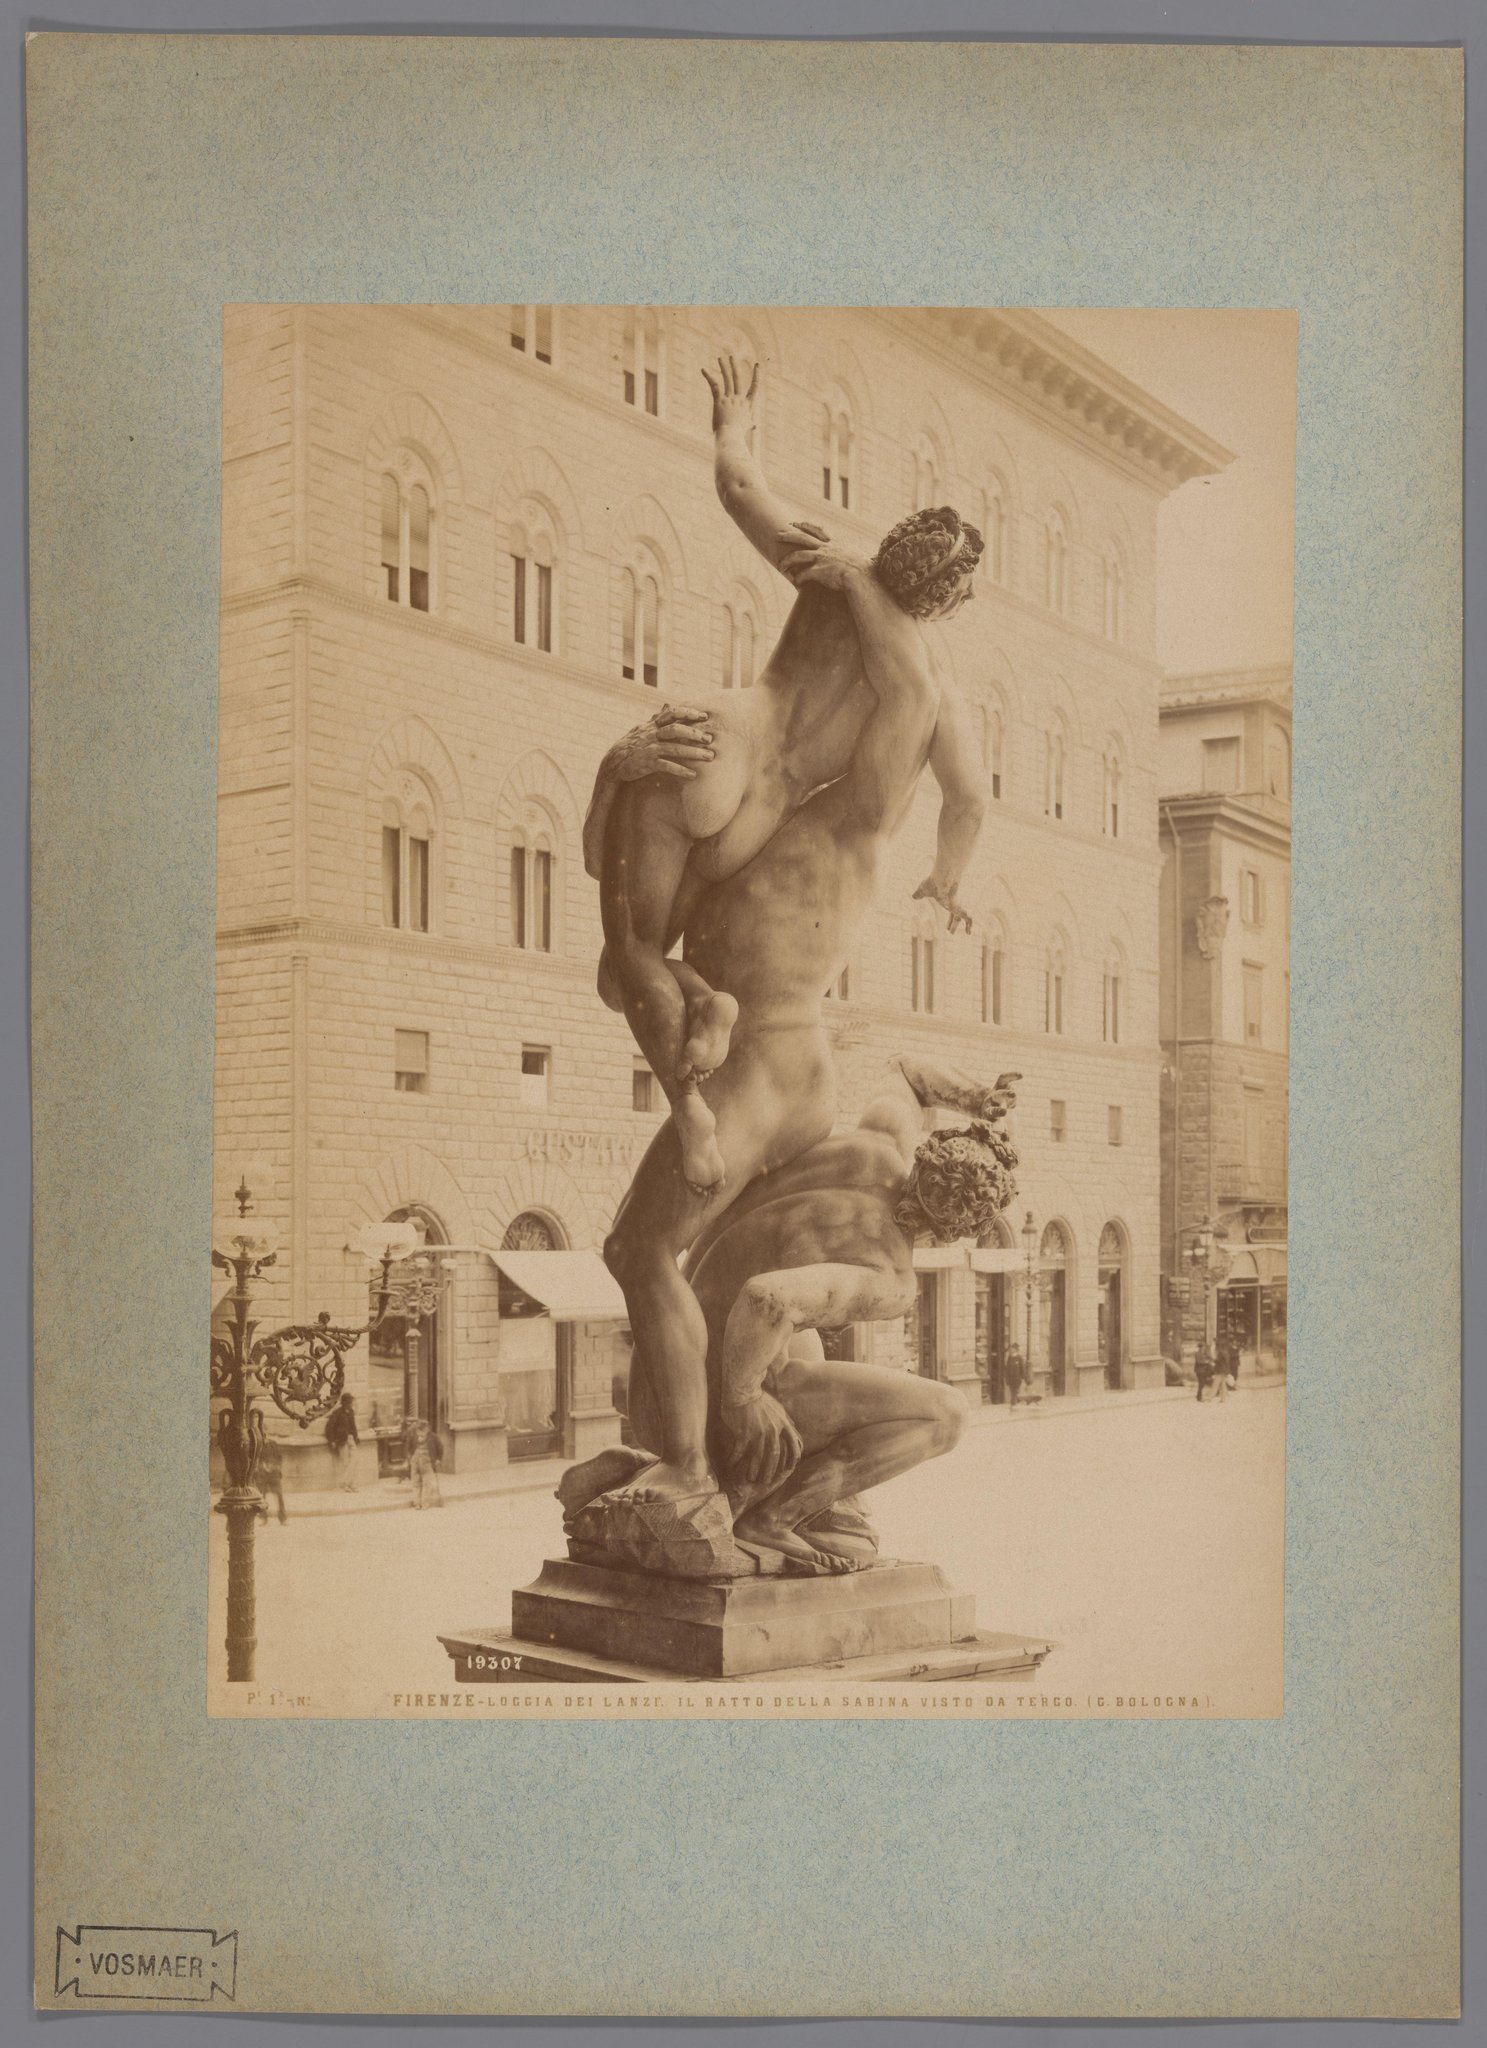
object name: photograph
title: Loggia dei Lanzi. Il Ratto della Sabina visto da Tergo (G. Bologna)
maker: giambologna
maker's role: draughtsman, goldsmith, sculptor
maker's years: 1524-1608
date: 1857-1900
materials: cardboard, paper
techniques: albumen print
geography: florence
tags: piece of sculpture, reproduction of a piece of sculpture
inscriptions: collector's mark: ‘VOSMAER’, number: ‘19307’, inscription: ‘Pt. 1A.-No.’